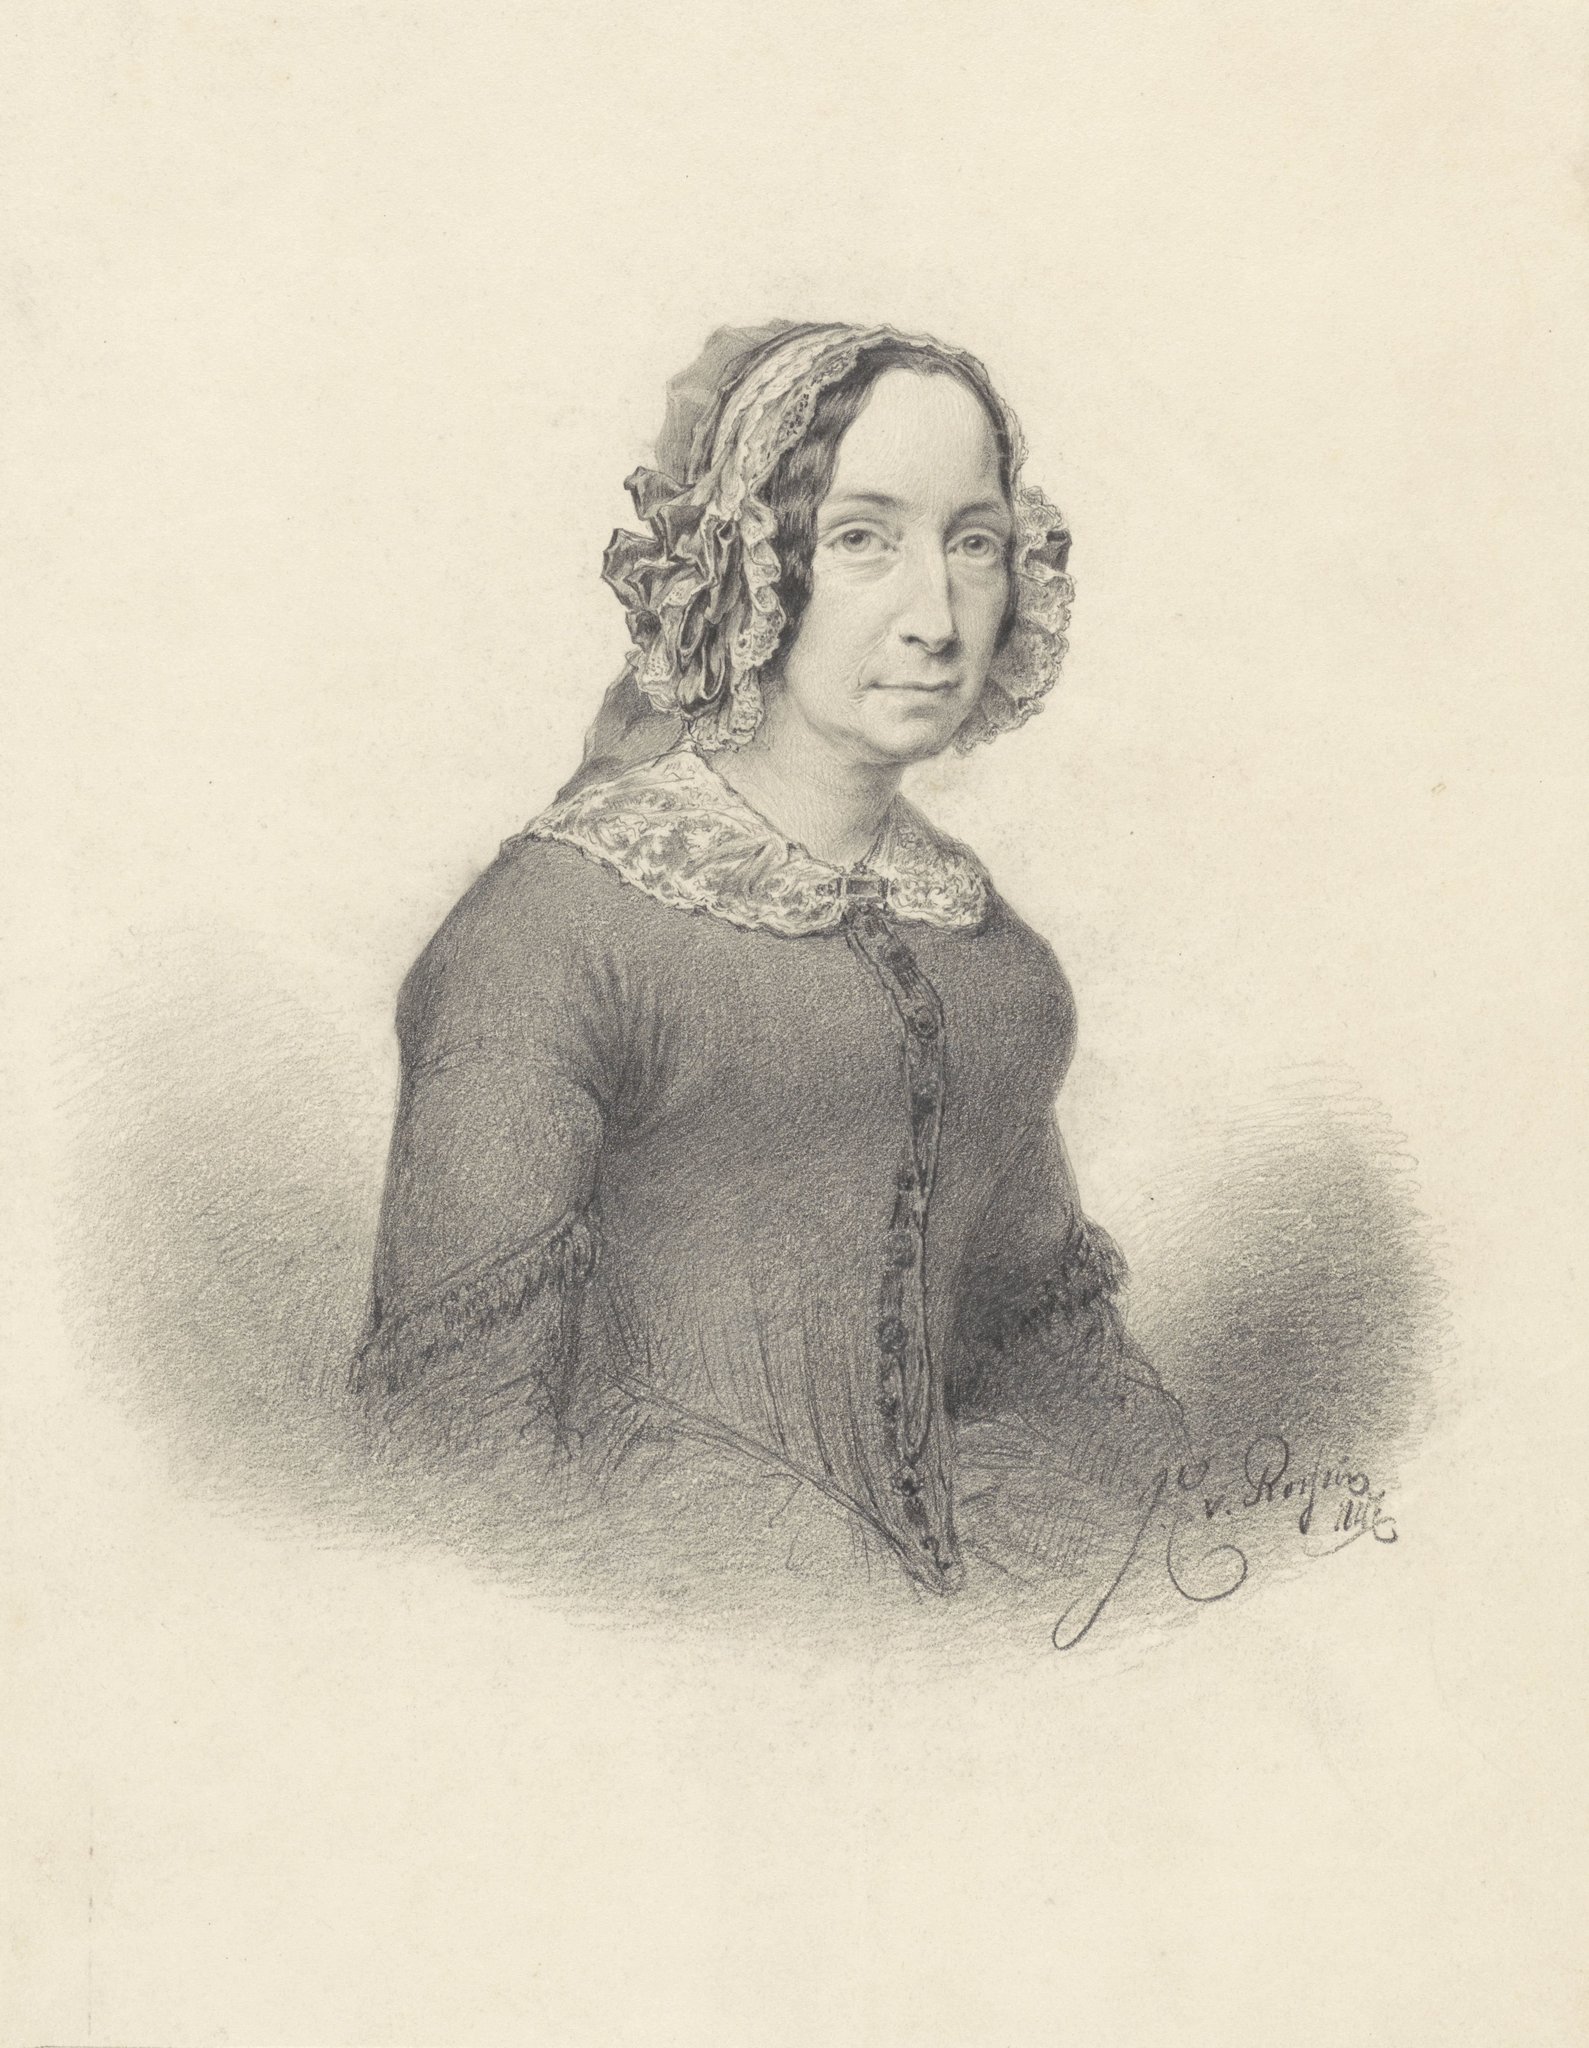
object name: drawing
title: Portret van een vrouw, driekwart naar rechts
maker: jan cornelis van rossum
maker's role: draughtsman, painter, print maker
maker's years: 1820-1905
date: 1847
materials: paper, pencil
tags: anonymous historical person portrayed alone